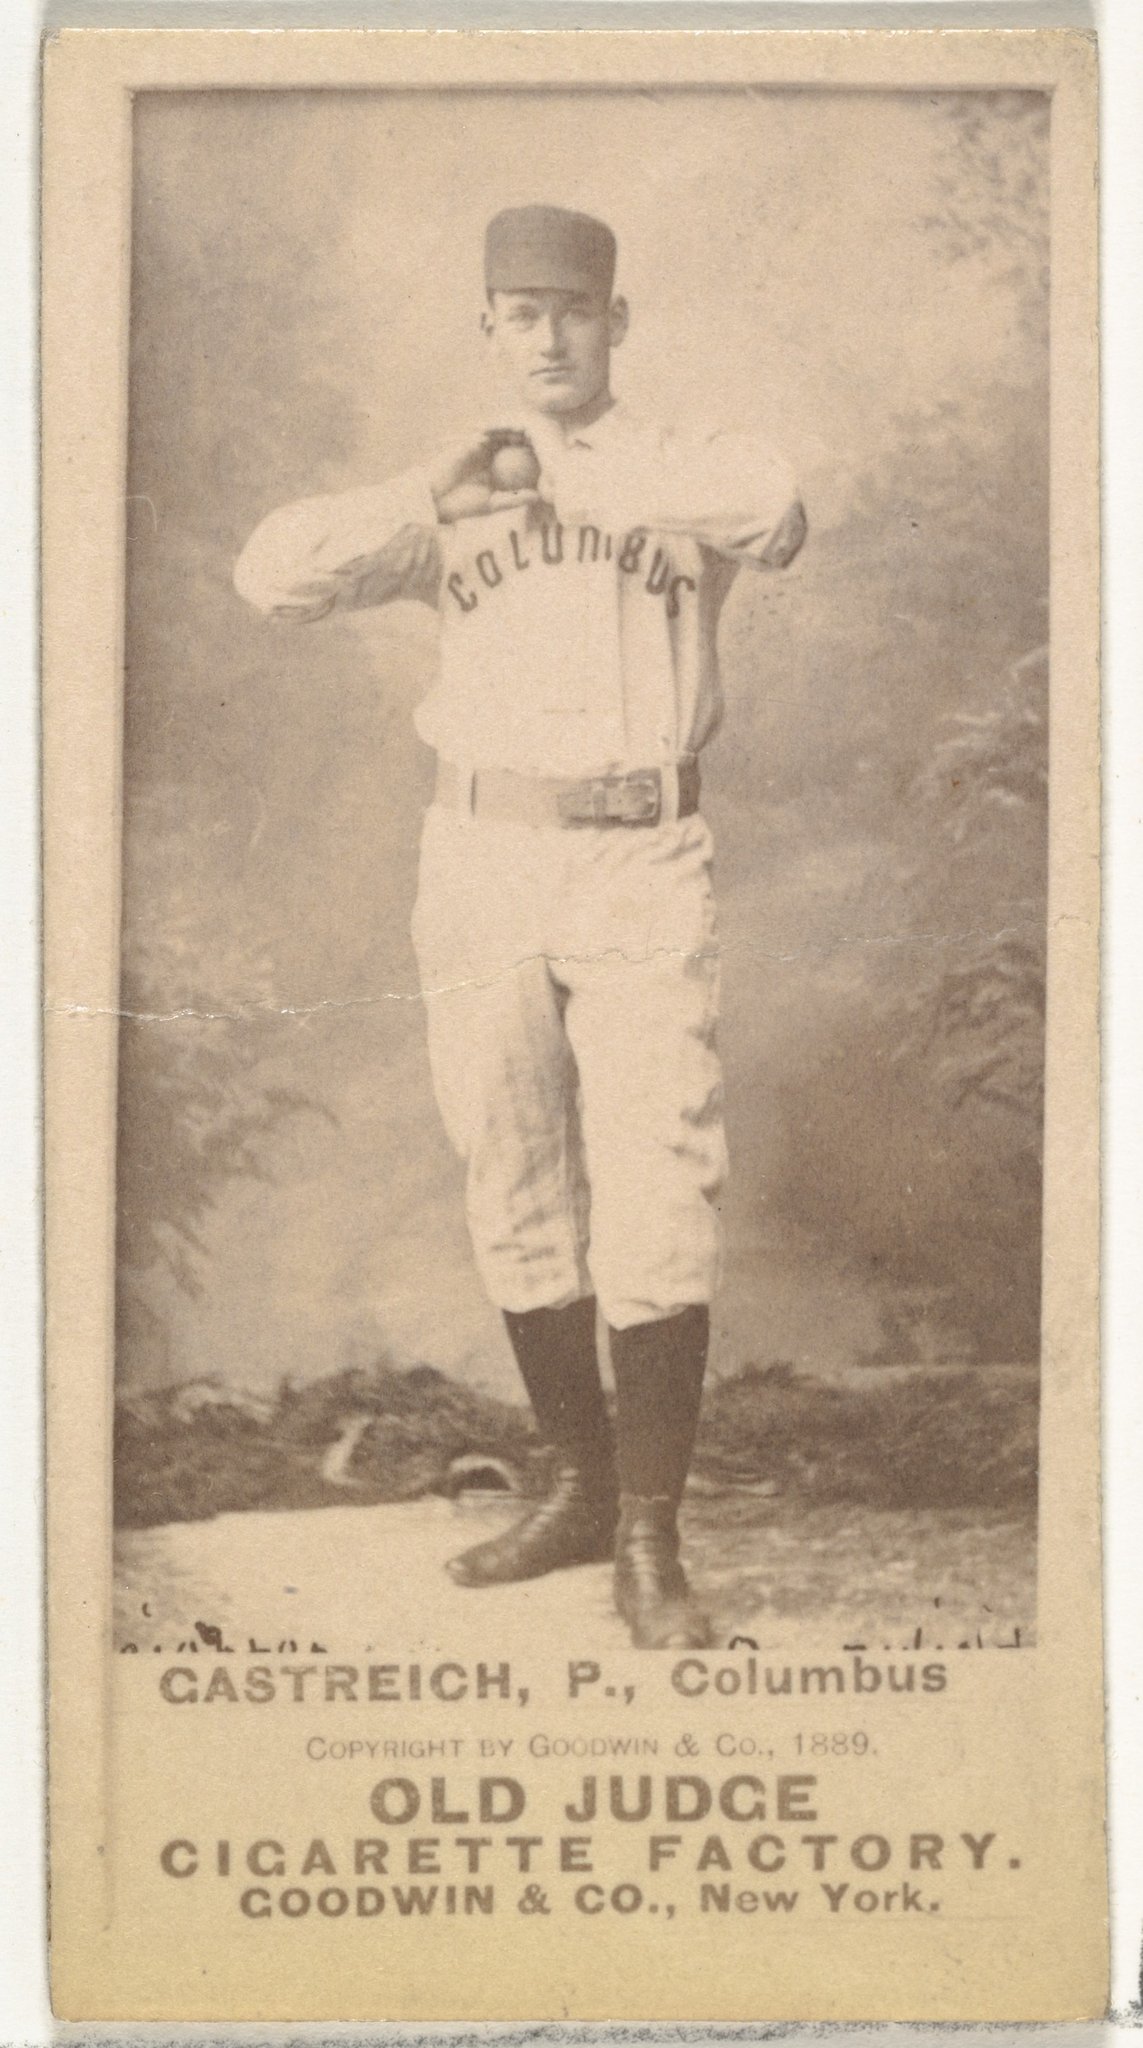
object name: baseball card, photograph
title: Henry Carl "Hank" Gastright, Pitcher, Cleveland, from the Old Judge series (N172) for Old Judge Cigarettes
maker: goodwin & company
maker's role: publisher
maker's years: 1850-1950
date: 1889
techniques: albumen silver print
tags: men,portraits,baseball,athletes